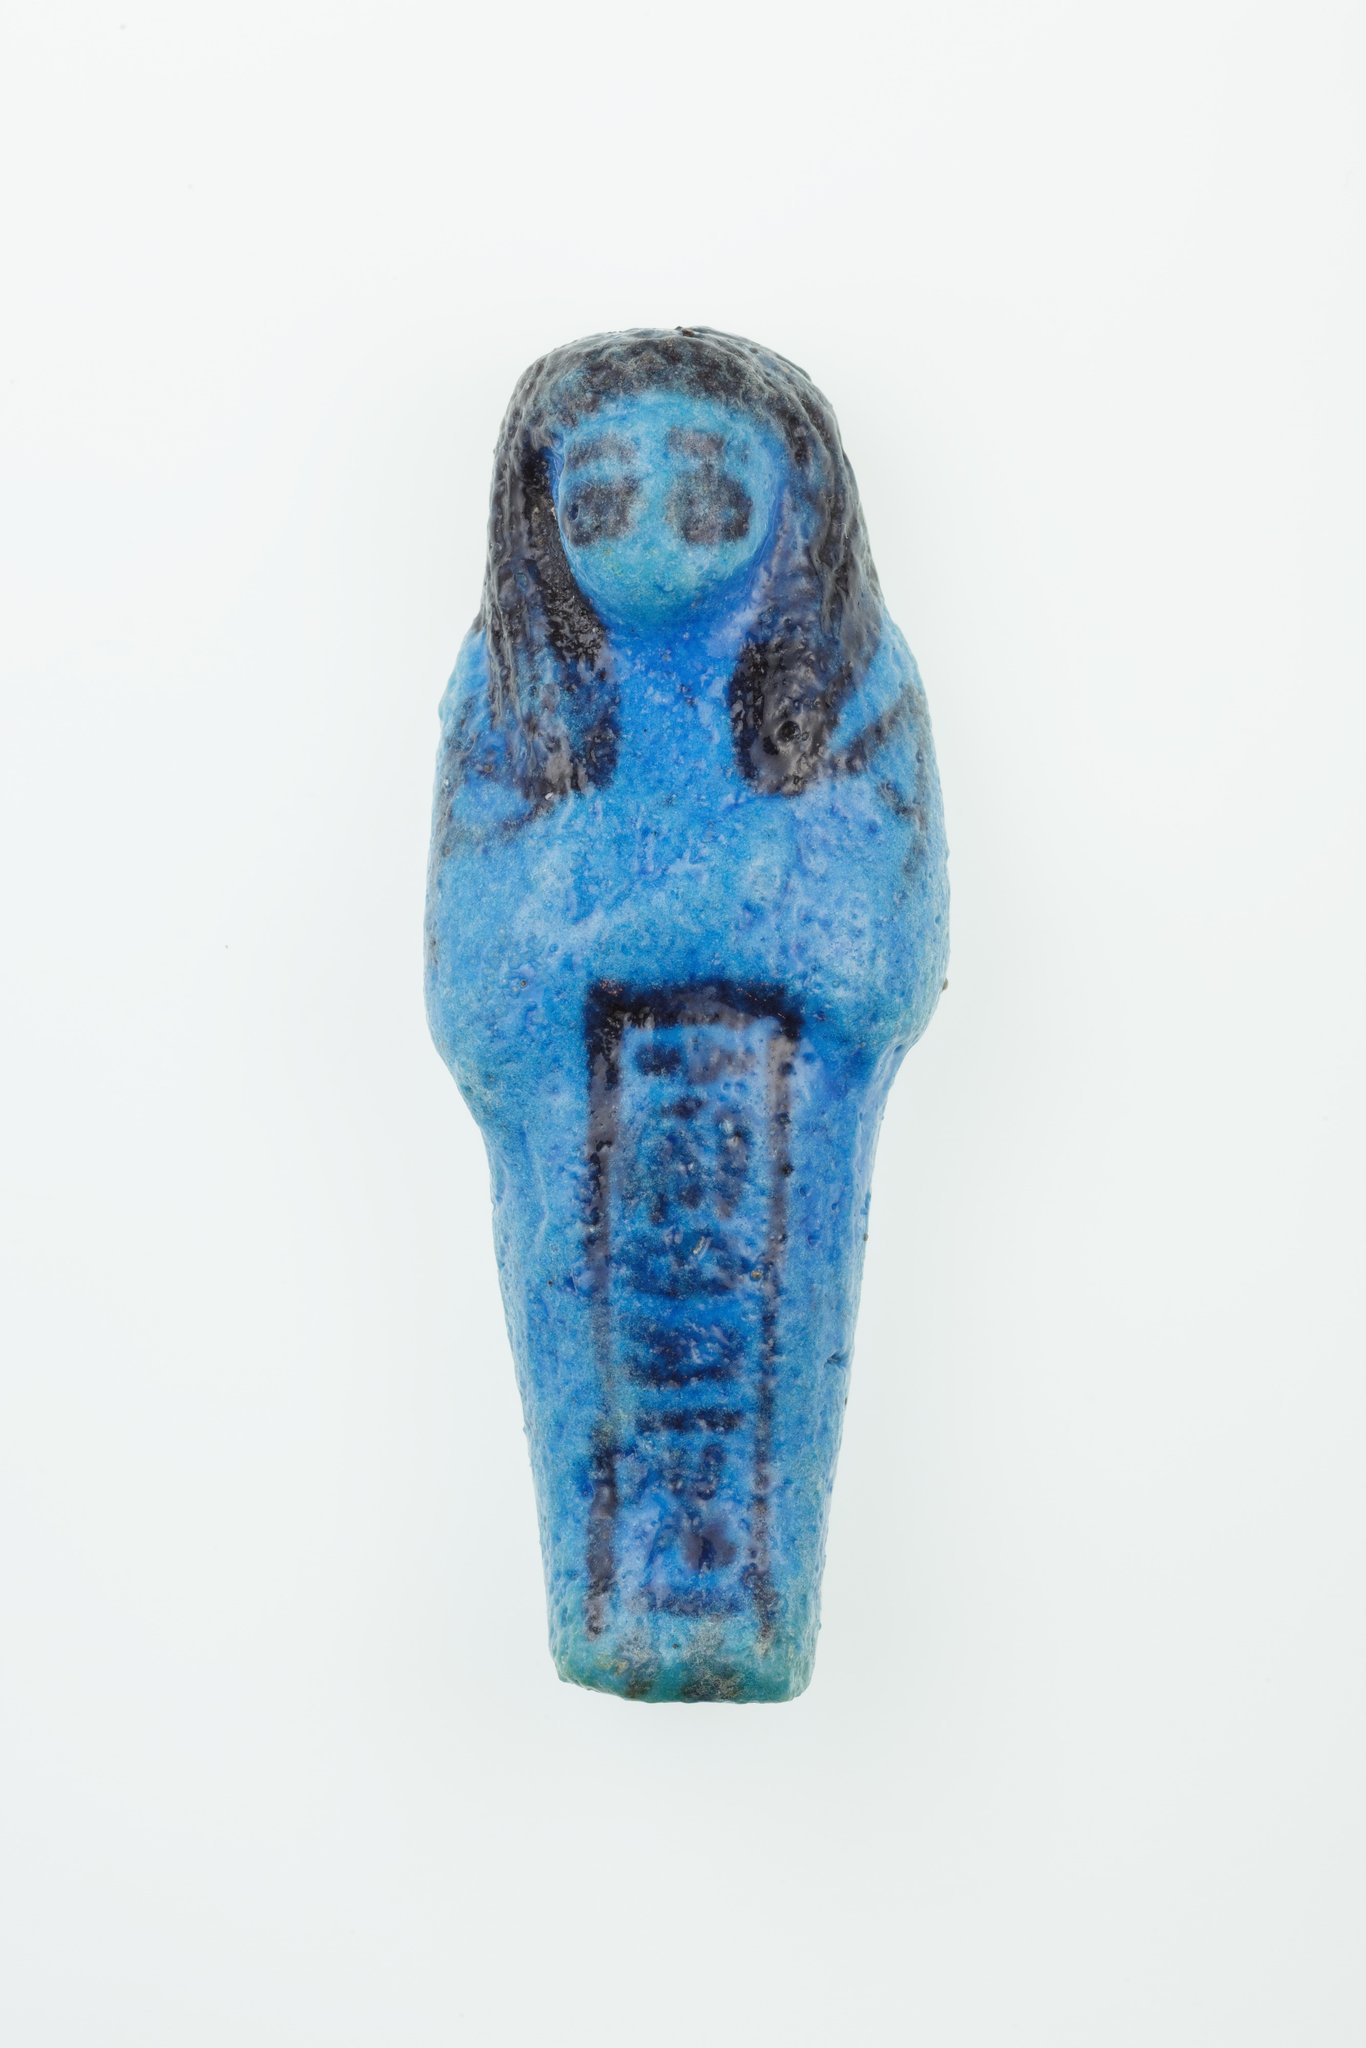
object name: shabti, worker, nauny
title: Worker Shabti of Nauny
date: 1050 BCE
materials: faience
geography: egypt